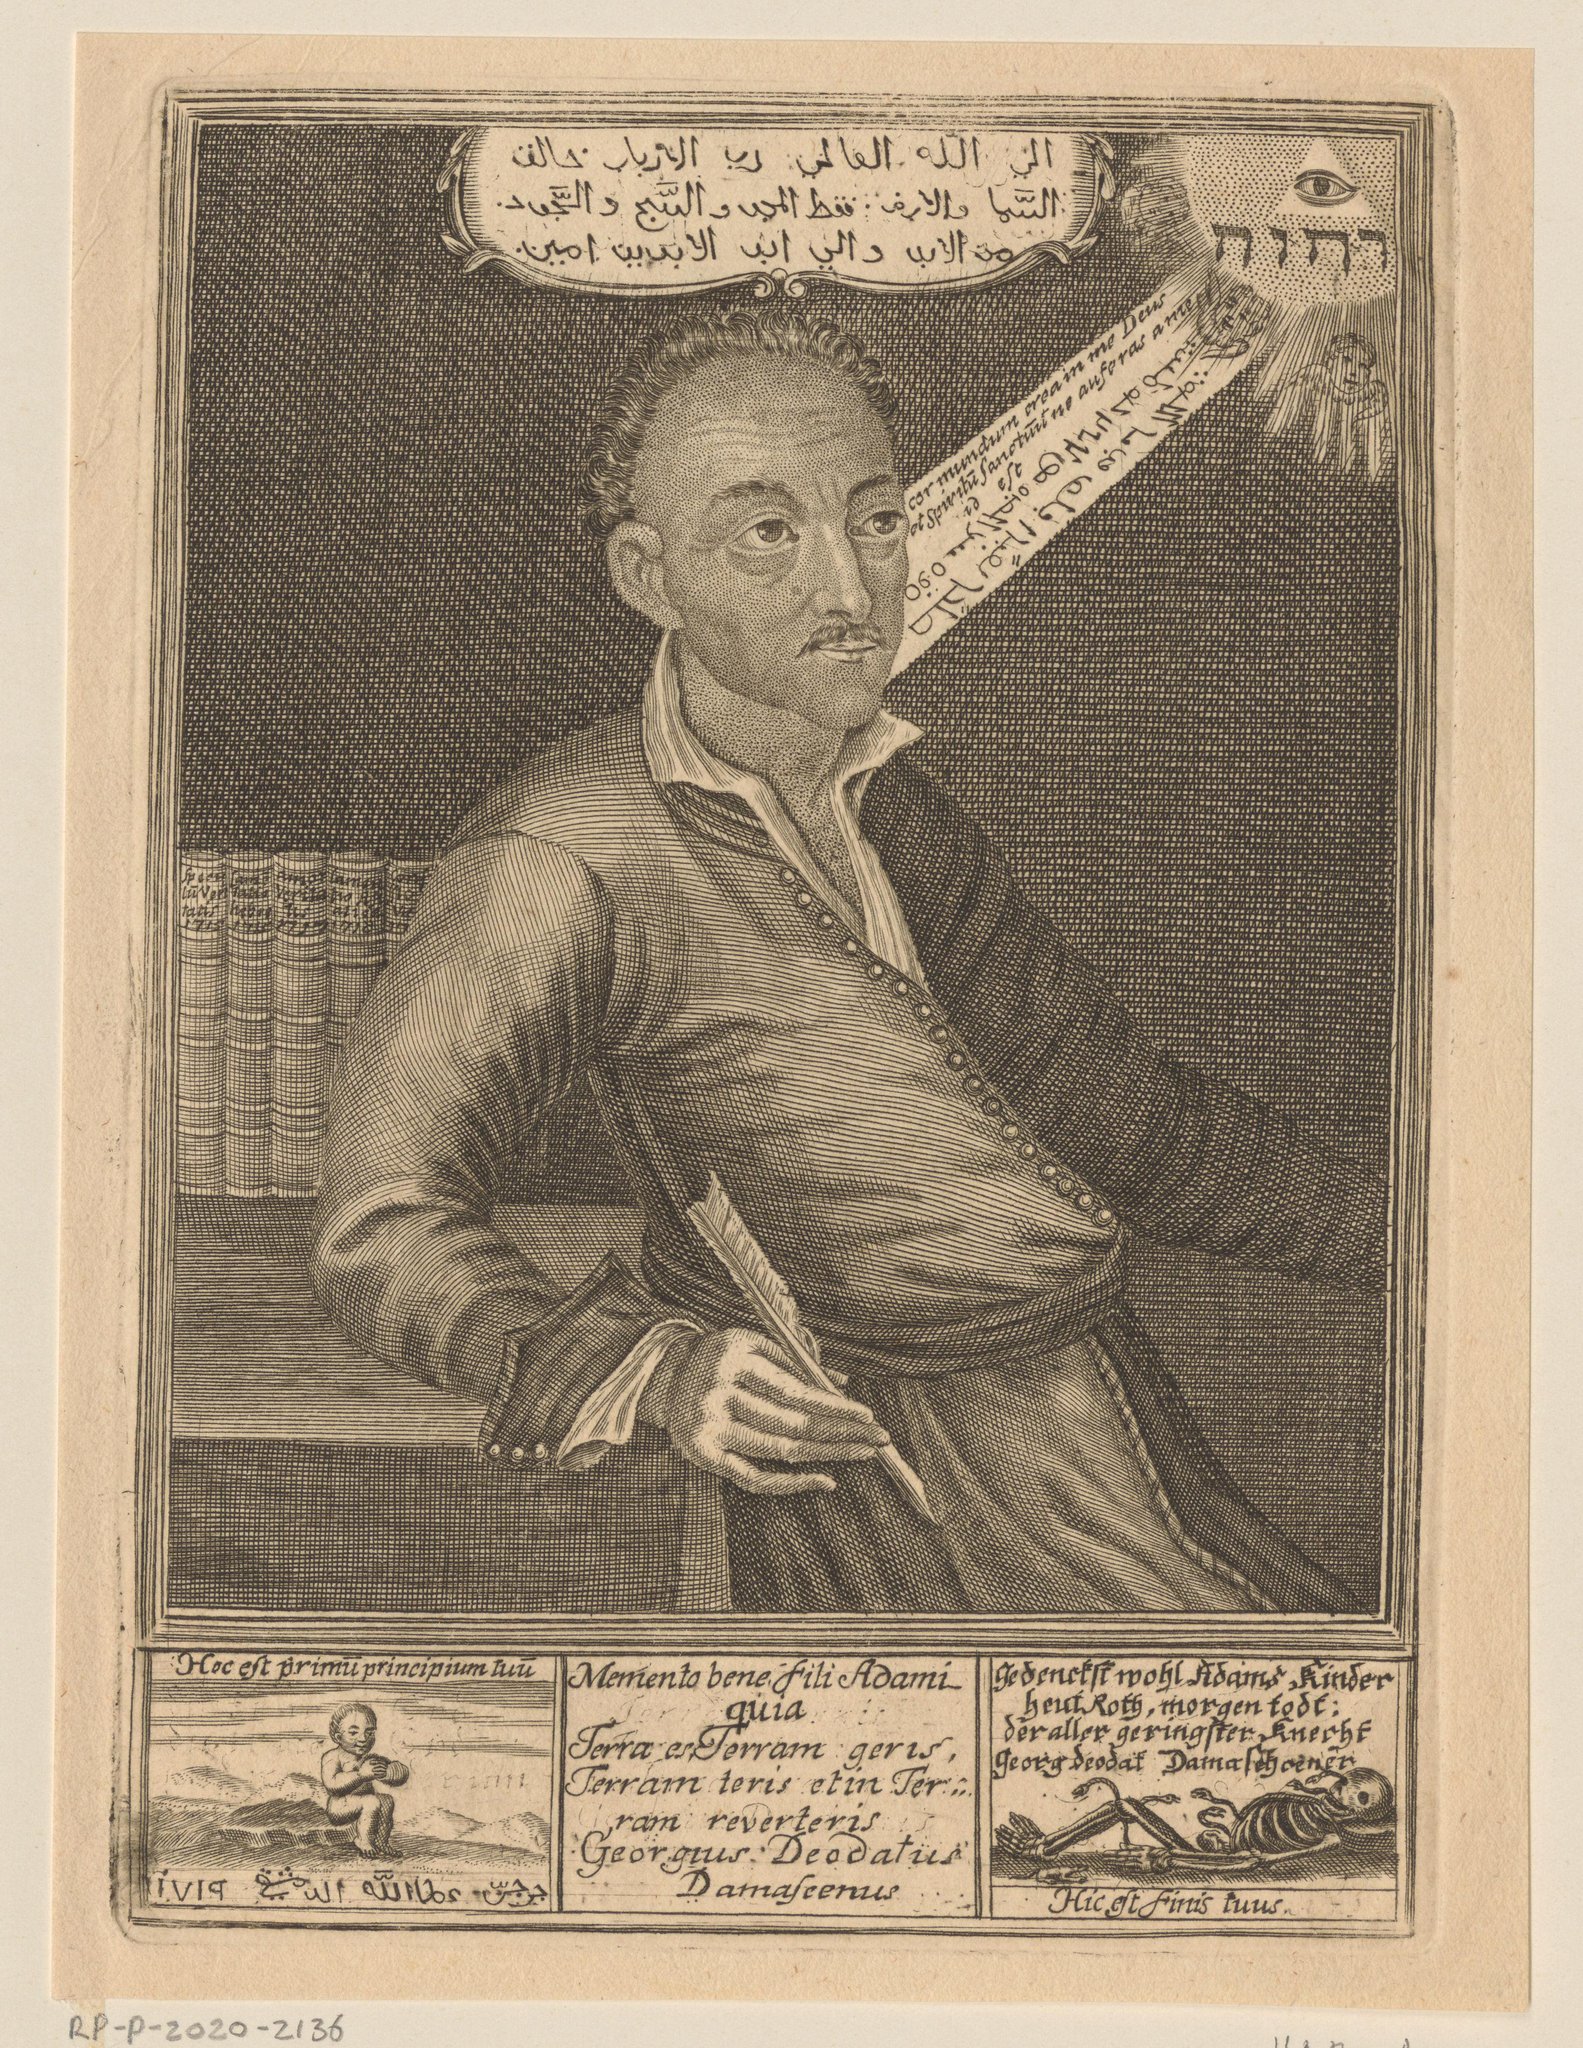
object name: print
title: Portret van Georgius Deodatus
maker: Anonymous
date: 1717-1731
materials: paper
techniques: engraving, etching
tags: prague, historical persons, portrait of a writer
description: Prent mogelijk uit: Deodatus, Georgius. Kurtze Vorstellung und Erklärung derer drey vornehmsten in der gantzen Welt befindlichen Glauben (...). Praag: Johann Wenzel Helm, [1717-1731].